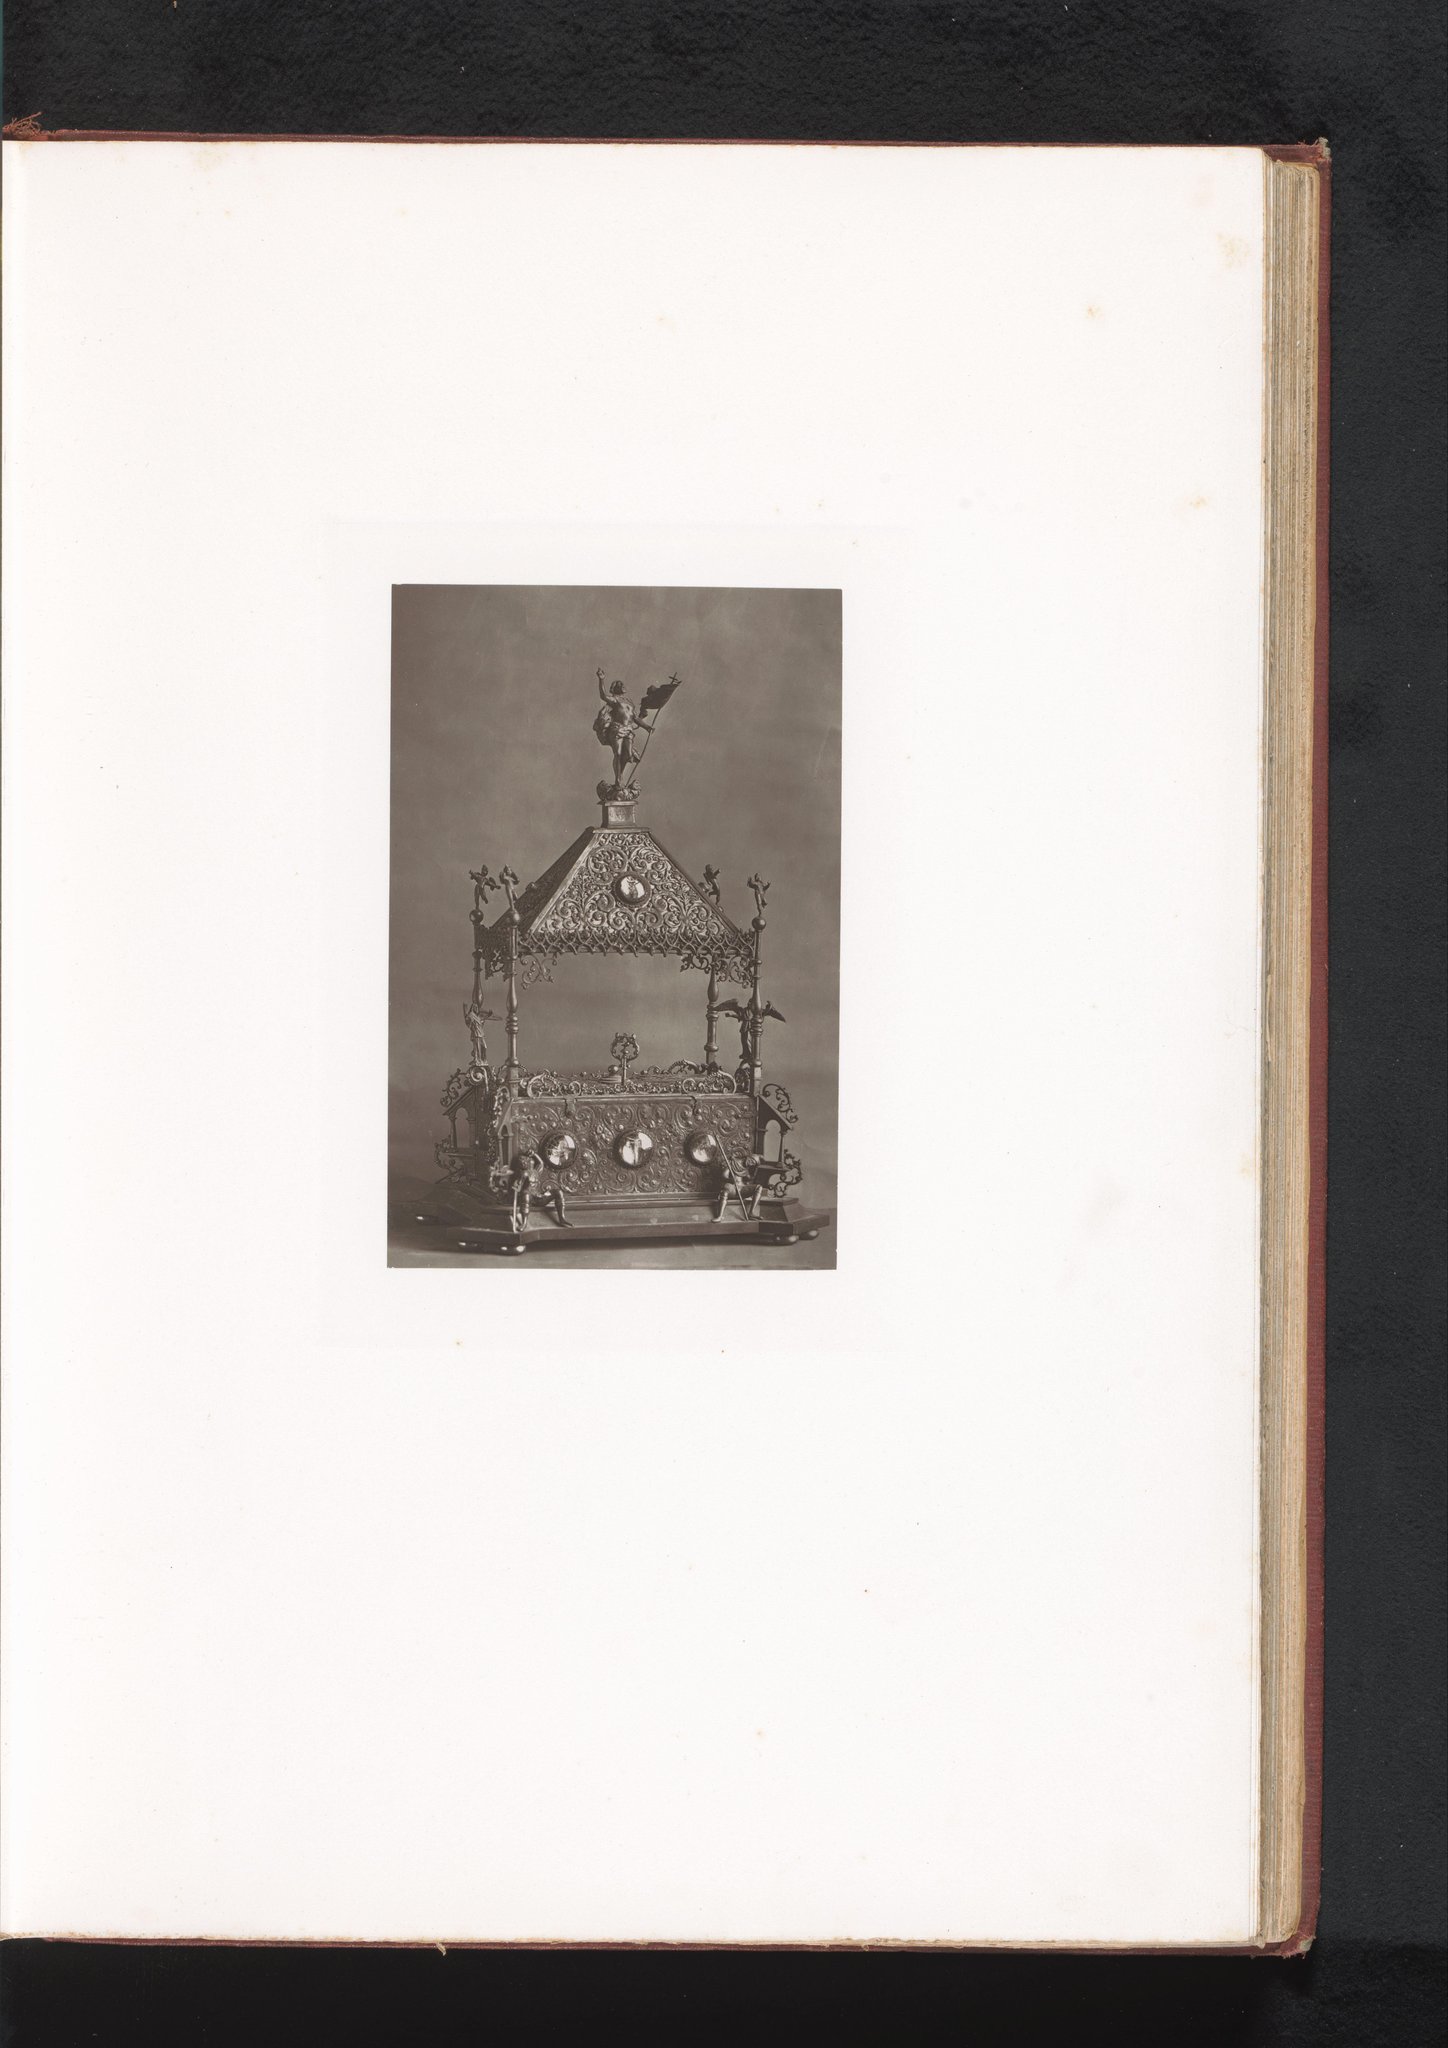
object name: photomechanical print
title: Relikwieënkast, opgesteld tijdens de Exposition Rétrospective van 1873 in Tours, Frankrijk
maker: gabriel blaise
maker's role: printer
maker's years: 1827-1897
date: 1873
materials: paper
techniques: woodburytype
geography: tours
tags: relics (and reliquaries), temporary exhibition, 'salon'